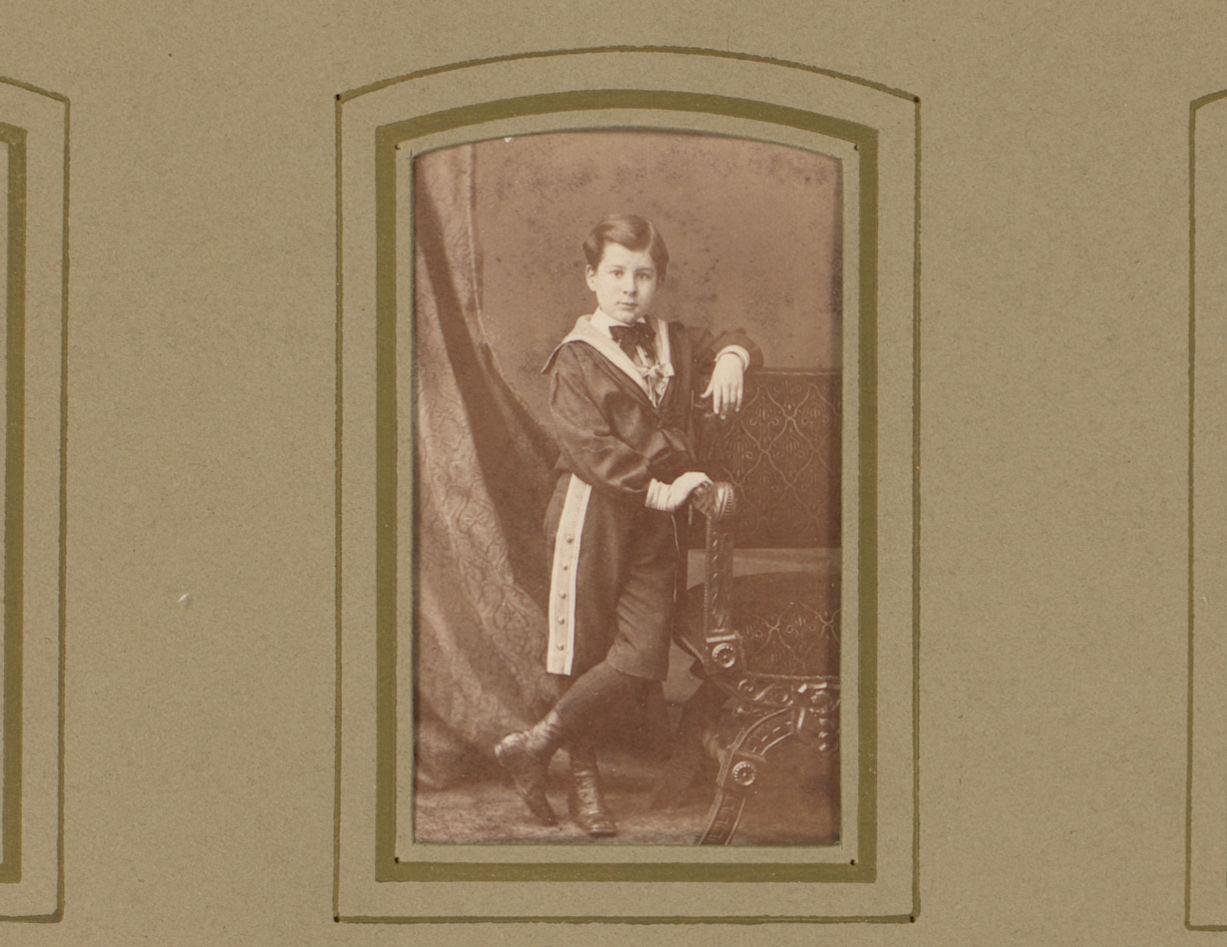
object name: photograph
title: Portret van een jongen, leunend op een stoel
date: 1867-1884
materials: cardboard, photographic support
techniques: albumen print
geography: netherlands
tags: boy (child between toddler and youth), historical persons, chair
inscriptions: inscription: ‘Photographisch Artistisch Atelier/ van/ Wegner & Mottu/ Amsterdam/ Rokin over de Bank/ 138./ Utrecht/ Hamburgerstraat/ F. 237./ Het cliché wordt voor verdere/ bestellingen bewaard.’, number: ‘5’